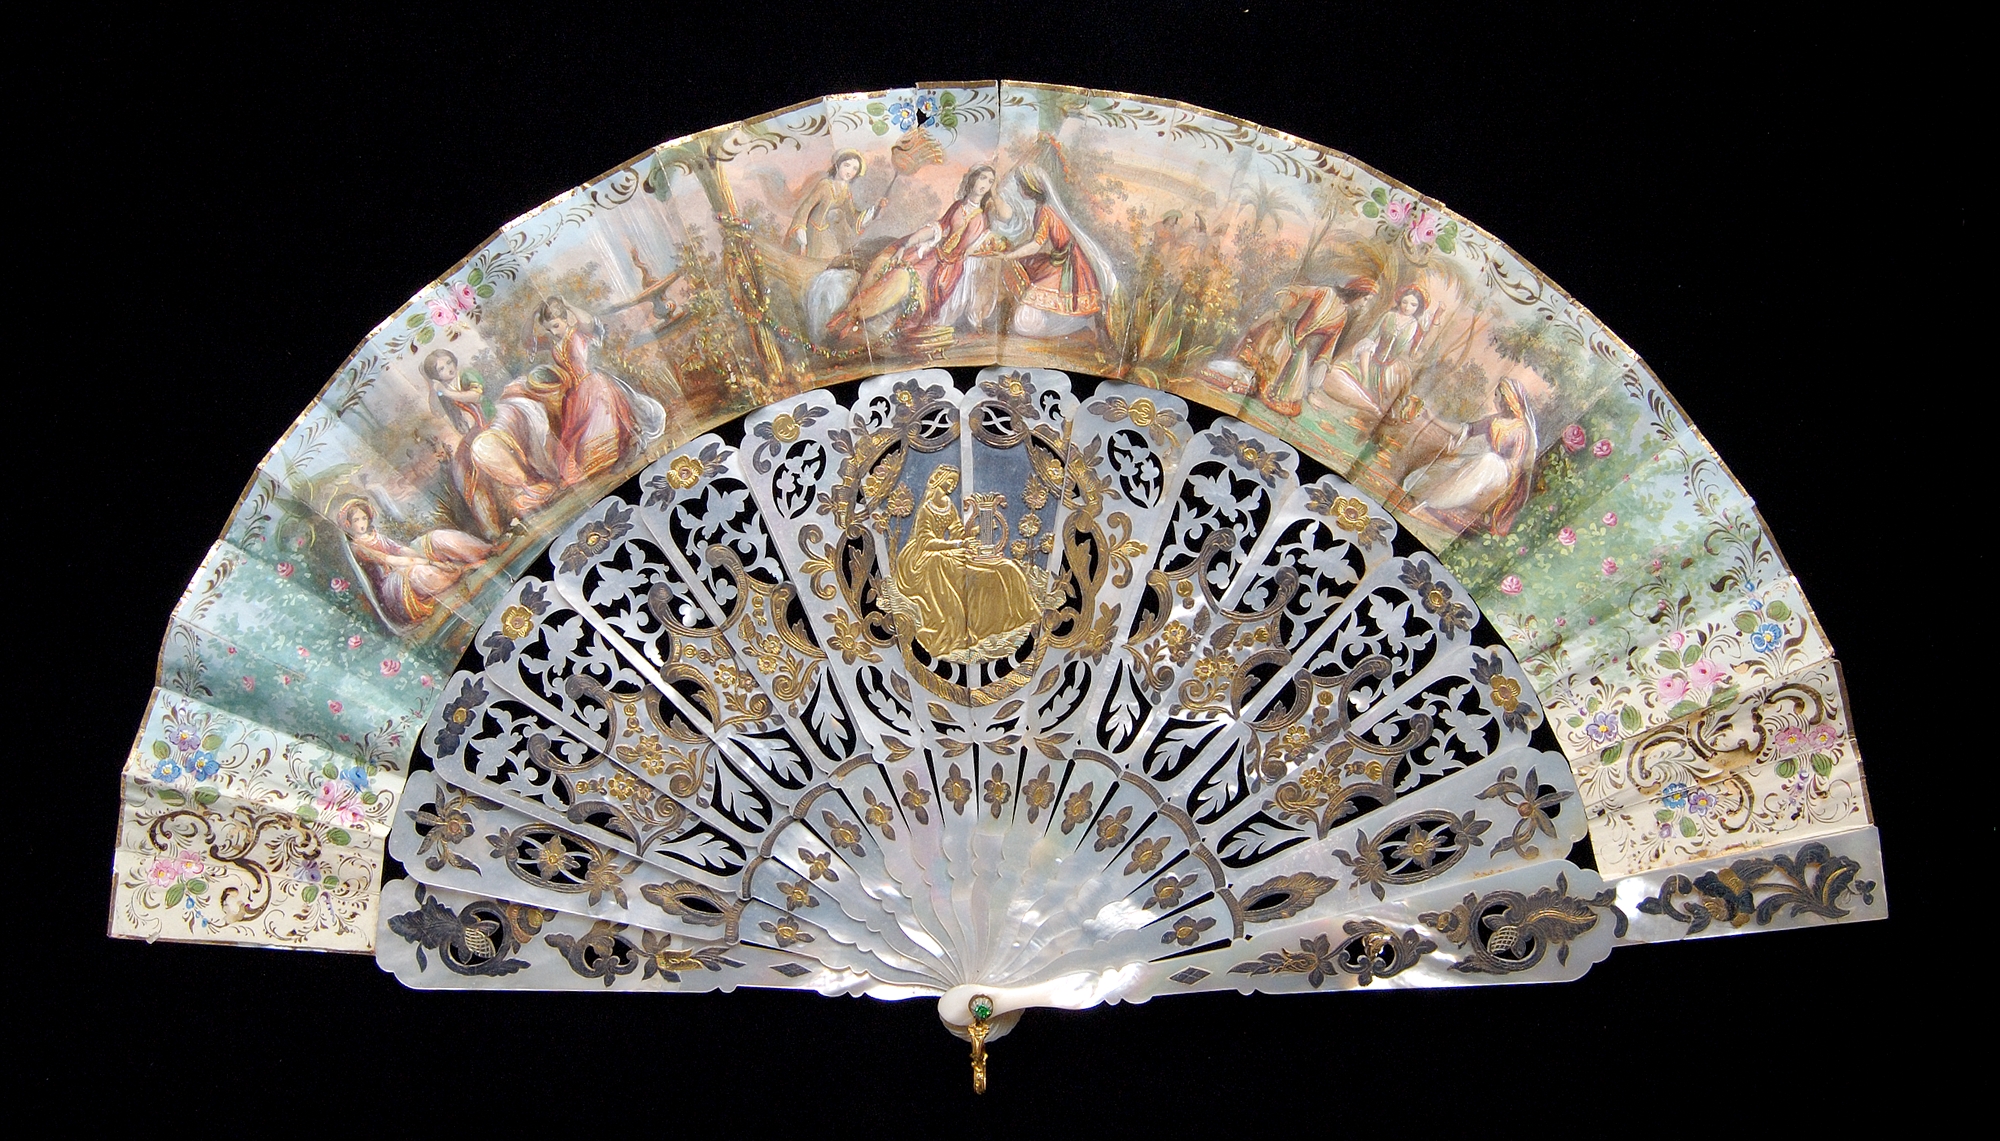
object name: fan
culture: european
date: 1860-1869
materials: metal, mother of pearl, paper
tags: men,women,flowers